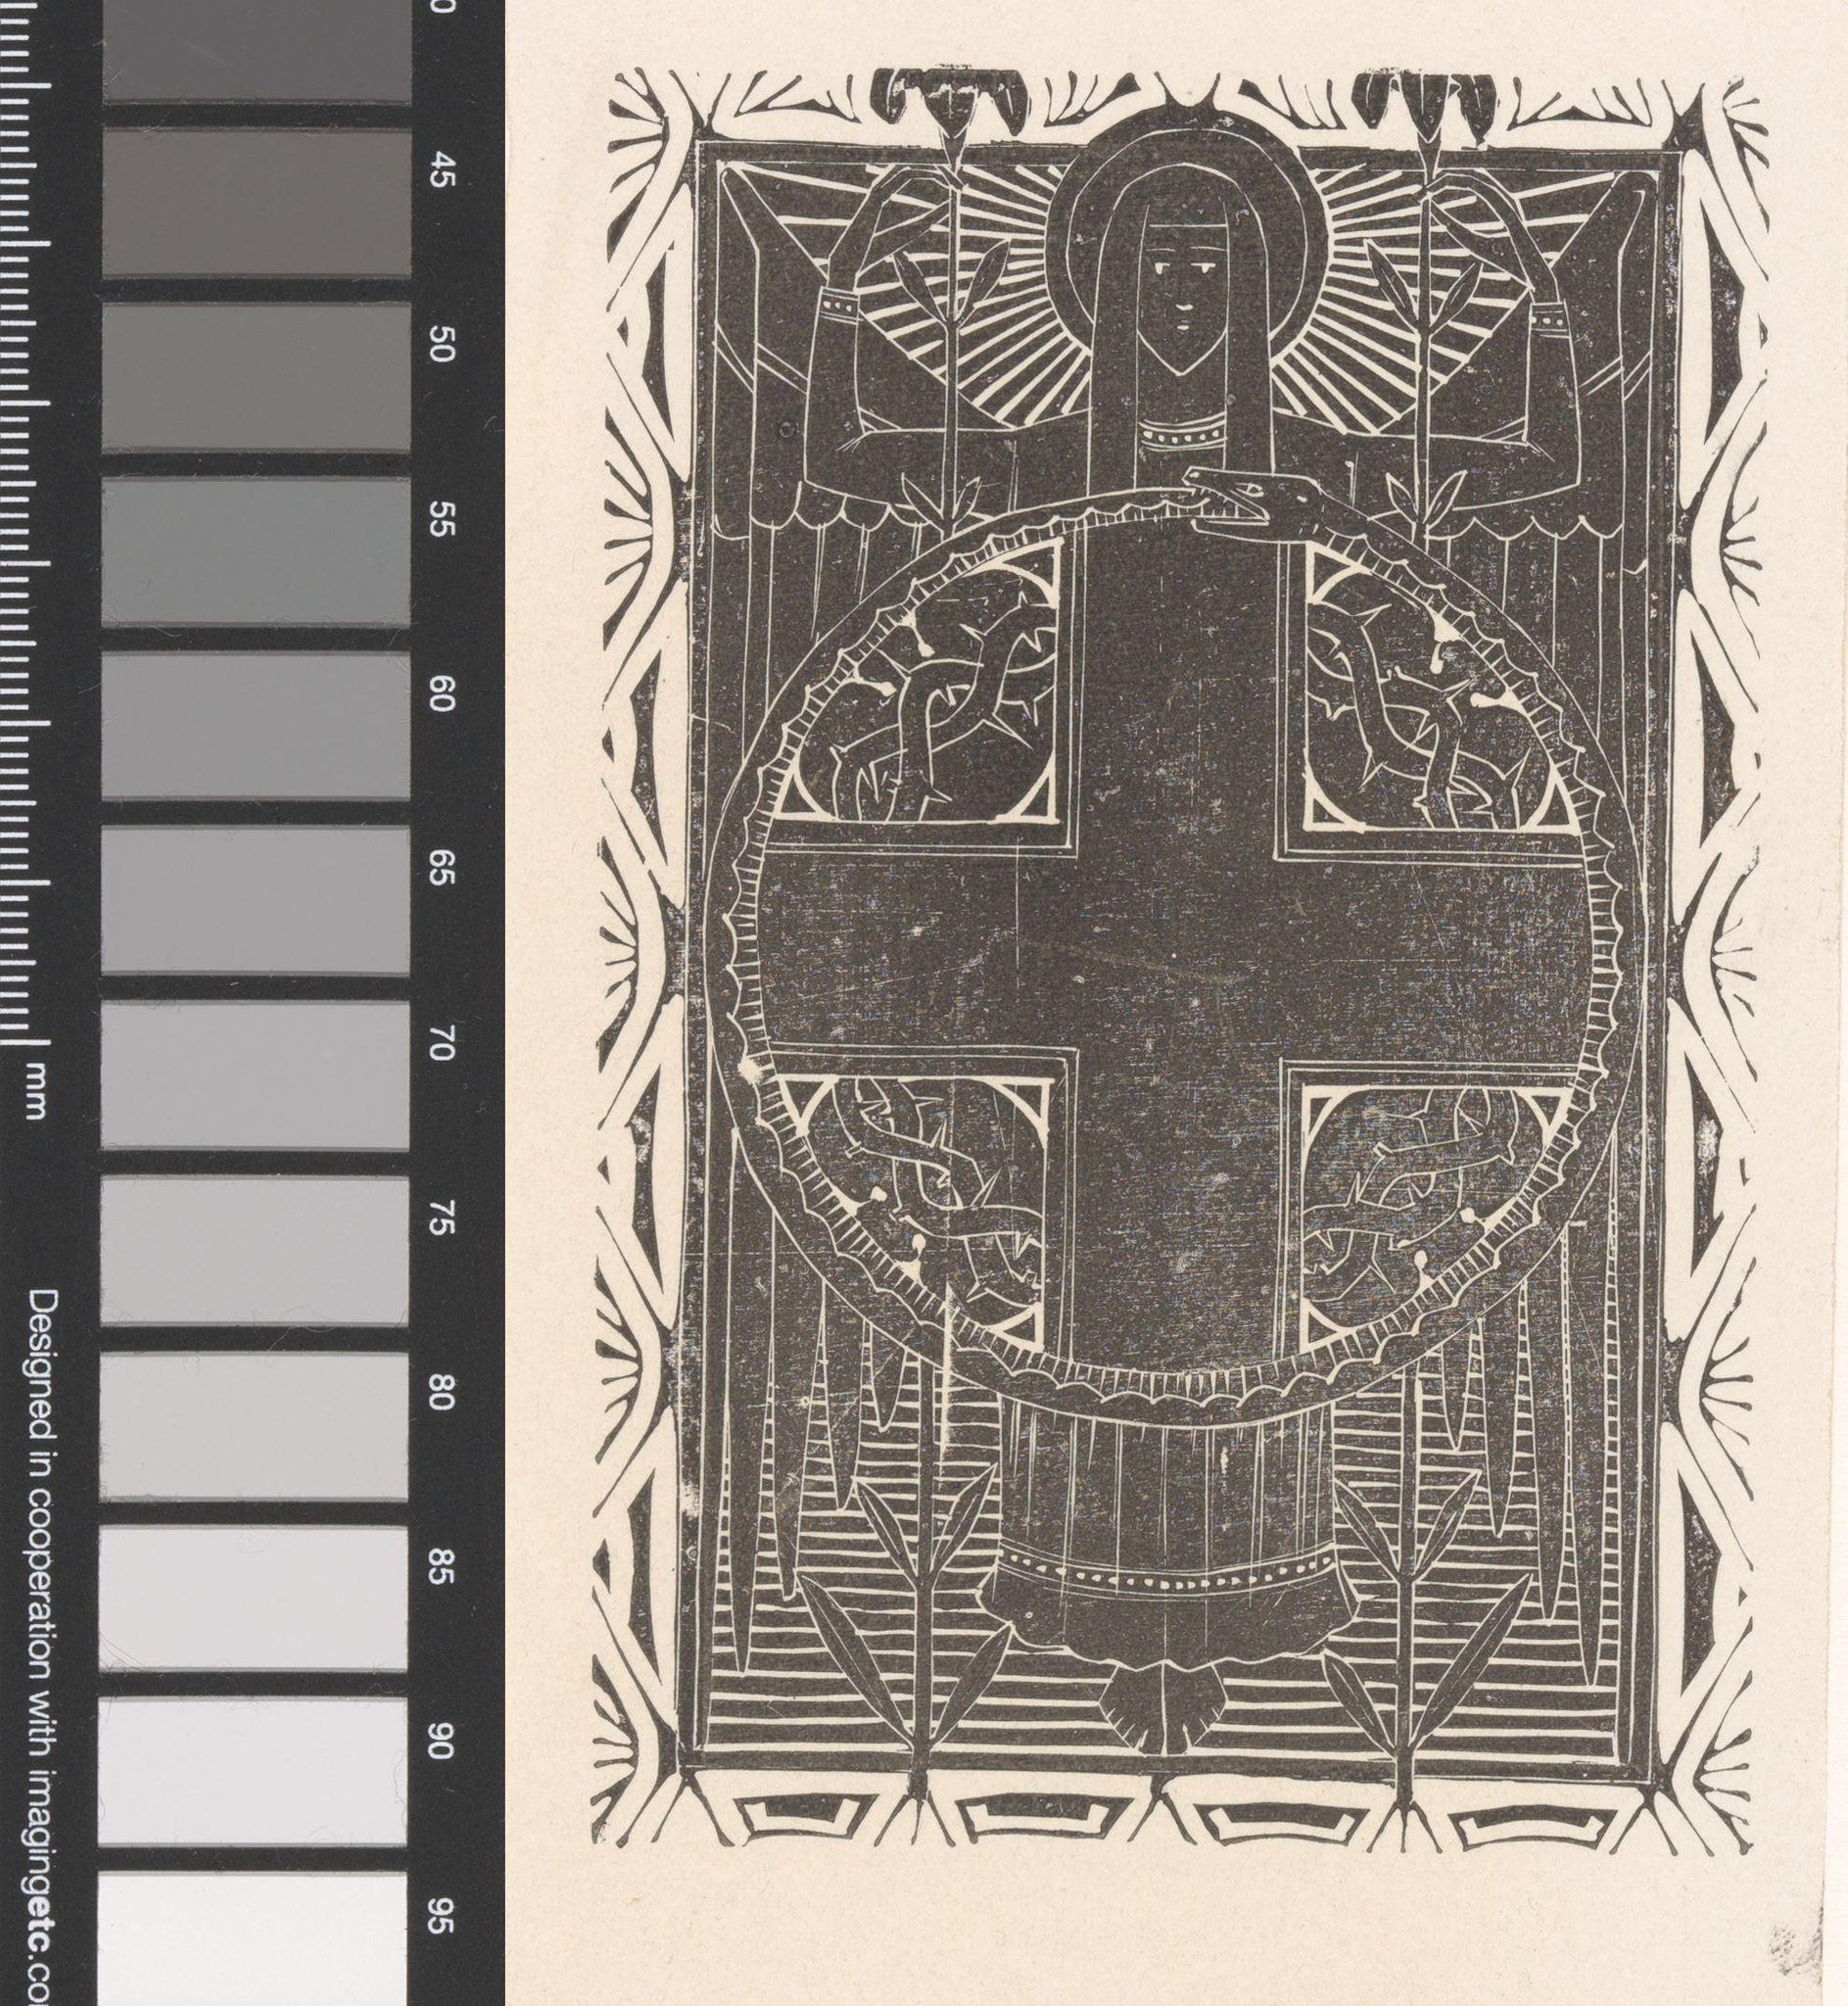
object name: prayer card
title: Kruis met ouroboros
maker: mathieu lauweriks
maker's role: designer, draughtsman, print maker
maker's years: 1864-1932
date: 1874-1932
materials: paper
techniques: woodcut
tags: nimbus, halo ~ radiance emanating from persons or things, the cross ~ symbols of christ, serpent ouroboros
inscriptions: collector's mark: Lugt 2228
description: Een kruis in een cirkel omgeven door een ouroboros, een slang die in zijn eigen staart bijt. Achter de cirkel een figuur met een nimbus die beide armen omhooghoudt.